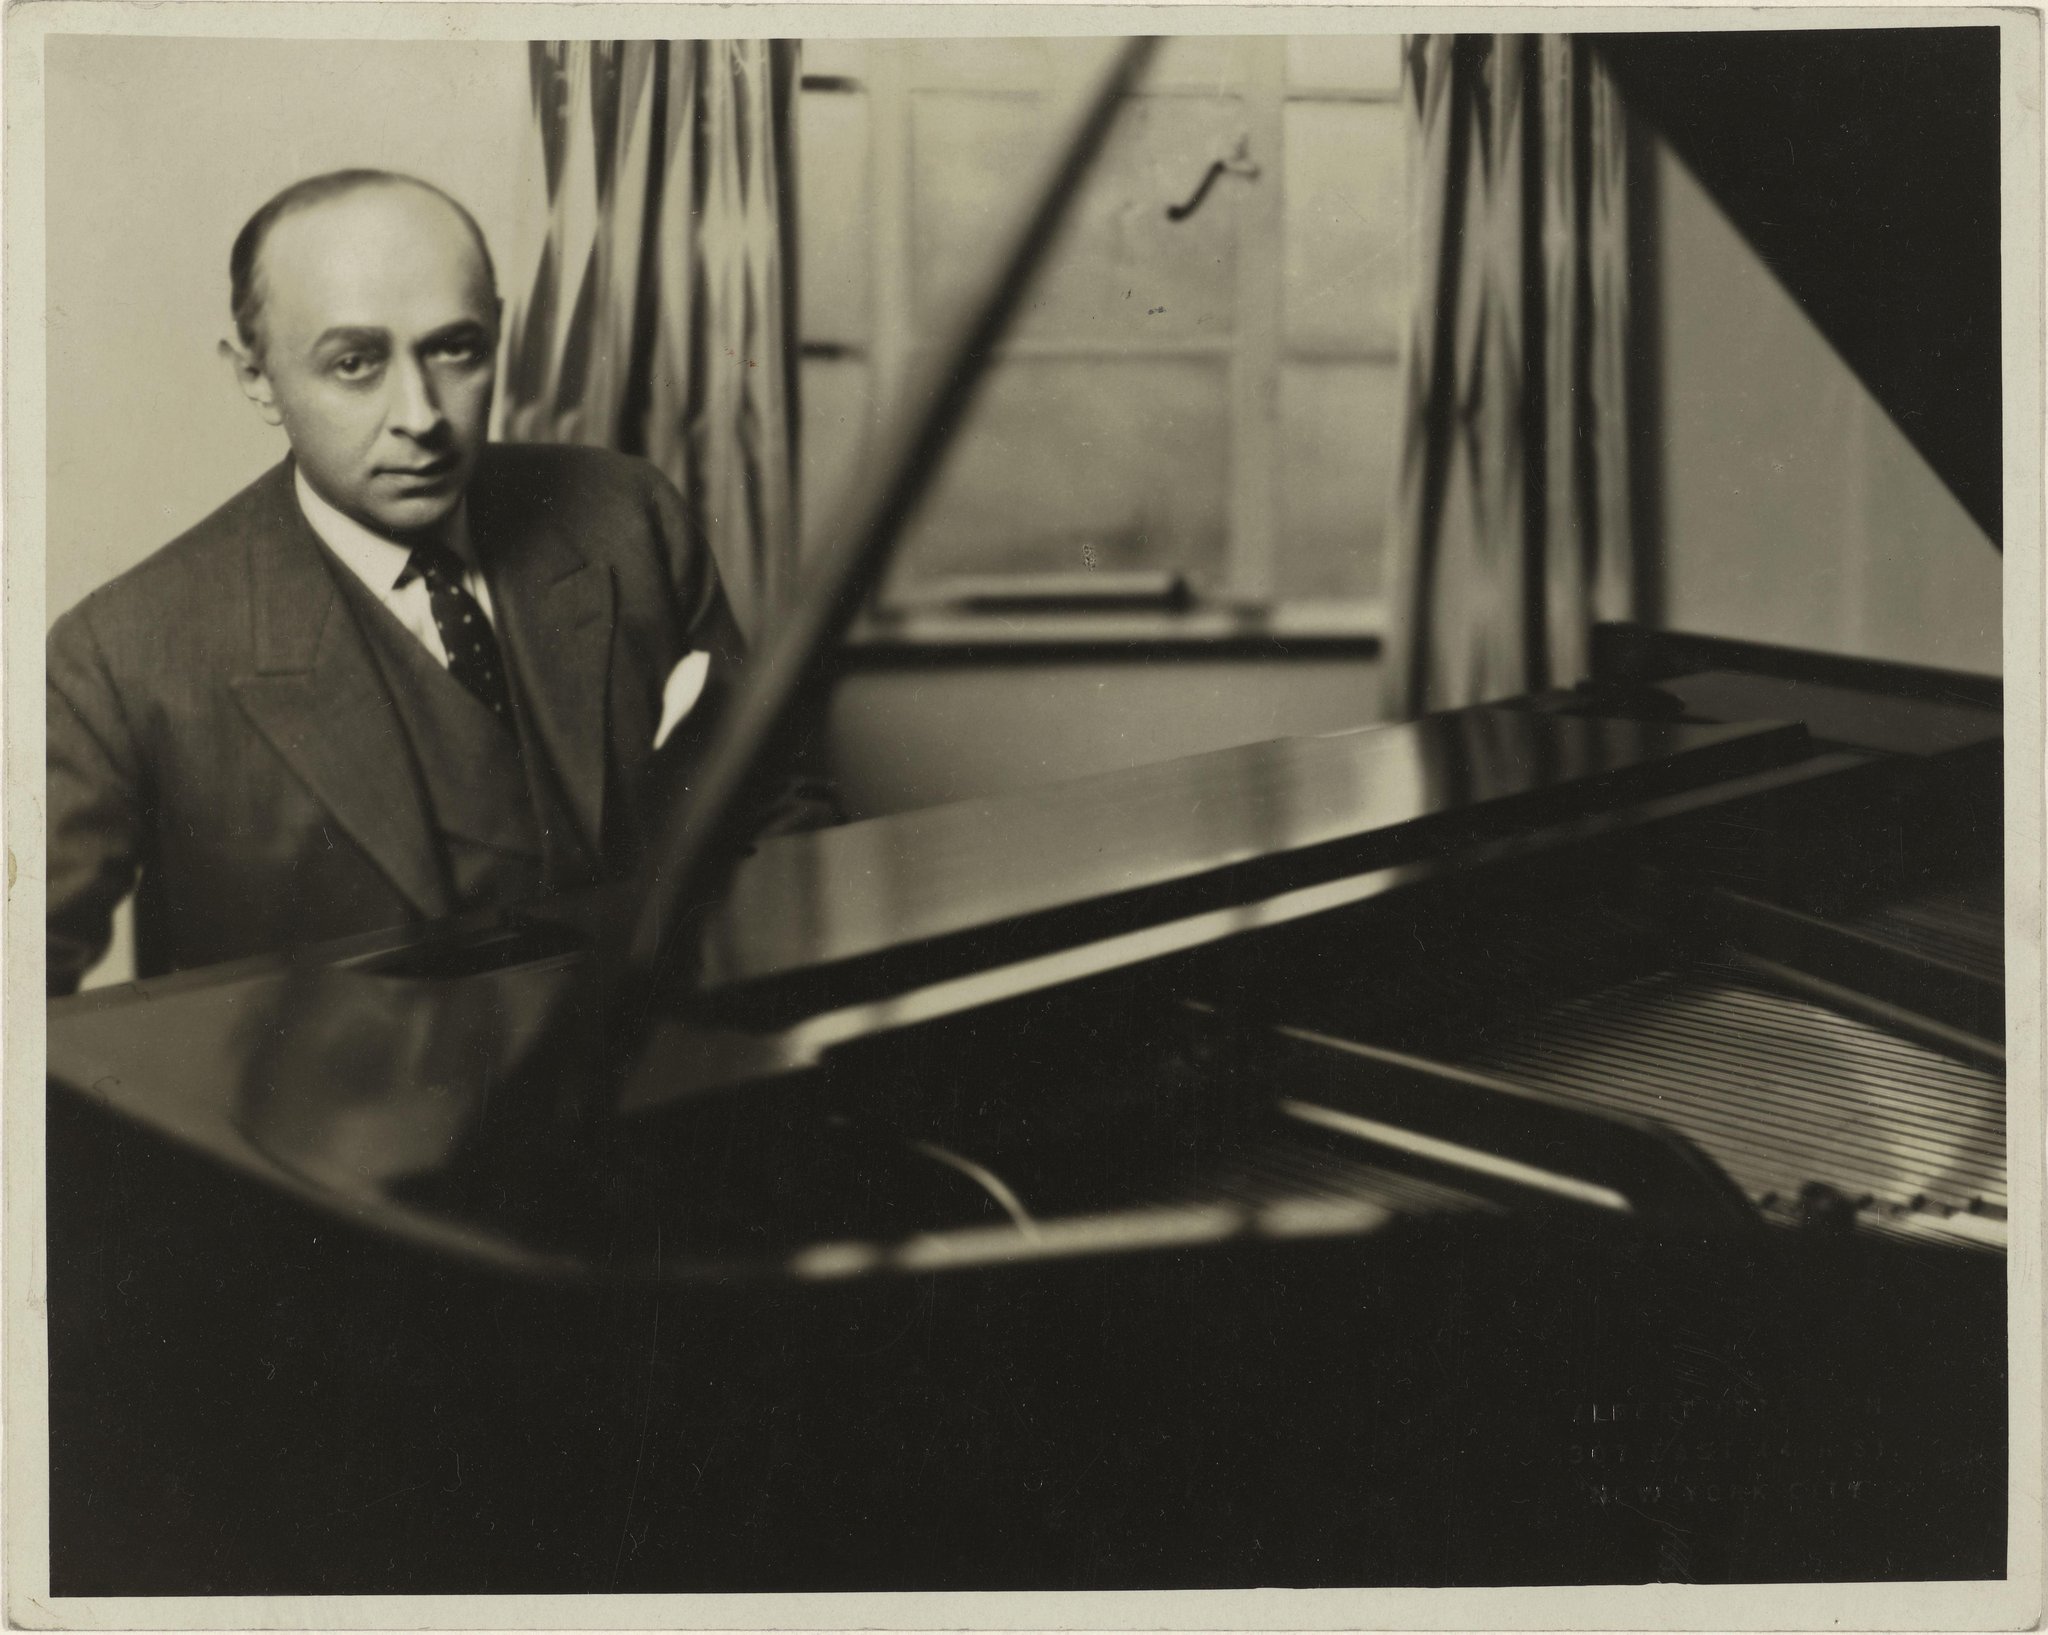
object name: photograph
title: Jan Smeterlin achter een piano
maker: albert petersen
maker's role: fotograaf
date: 1930-1940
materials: paper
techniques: gelatin silver print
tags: london, one person playing keyboard instrument, clavichord, harpsichord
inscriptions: inscription: ‘foto afkomstig [...]’, inscription: ‘Newspaper and Journals, This Portrait may be published/ when due credit is given to, ALBERT PETERSEN’, number: ‘#1517’, address: ‘ALBERT PETERSEN/ 307 EAST 44TH ST./ NEW YORK CITY’